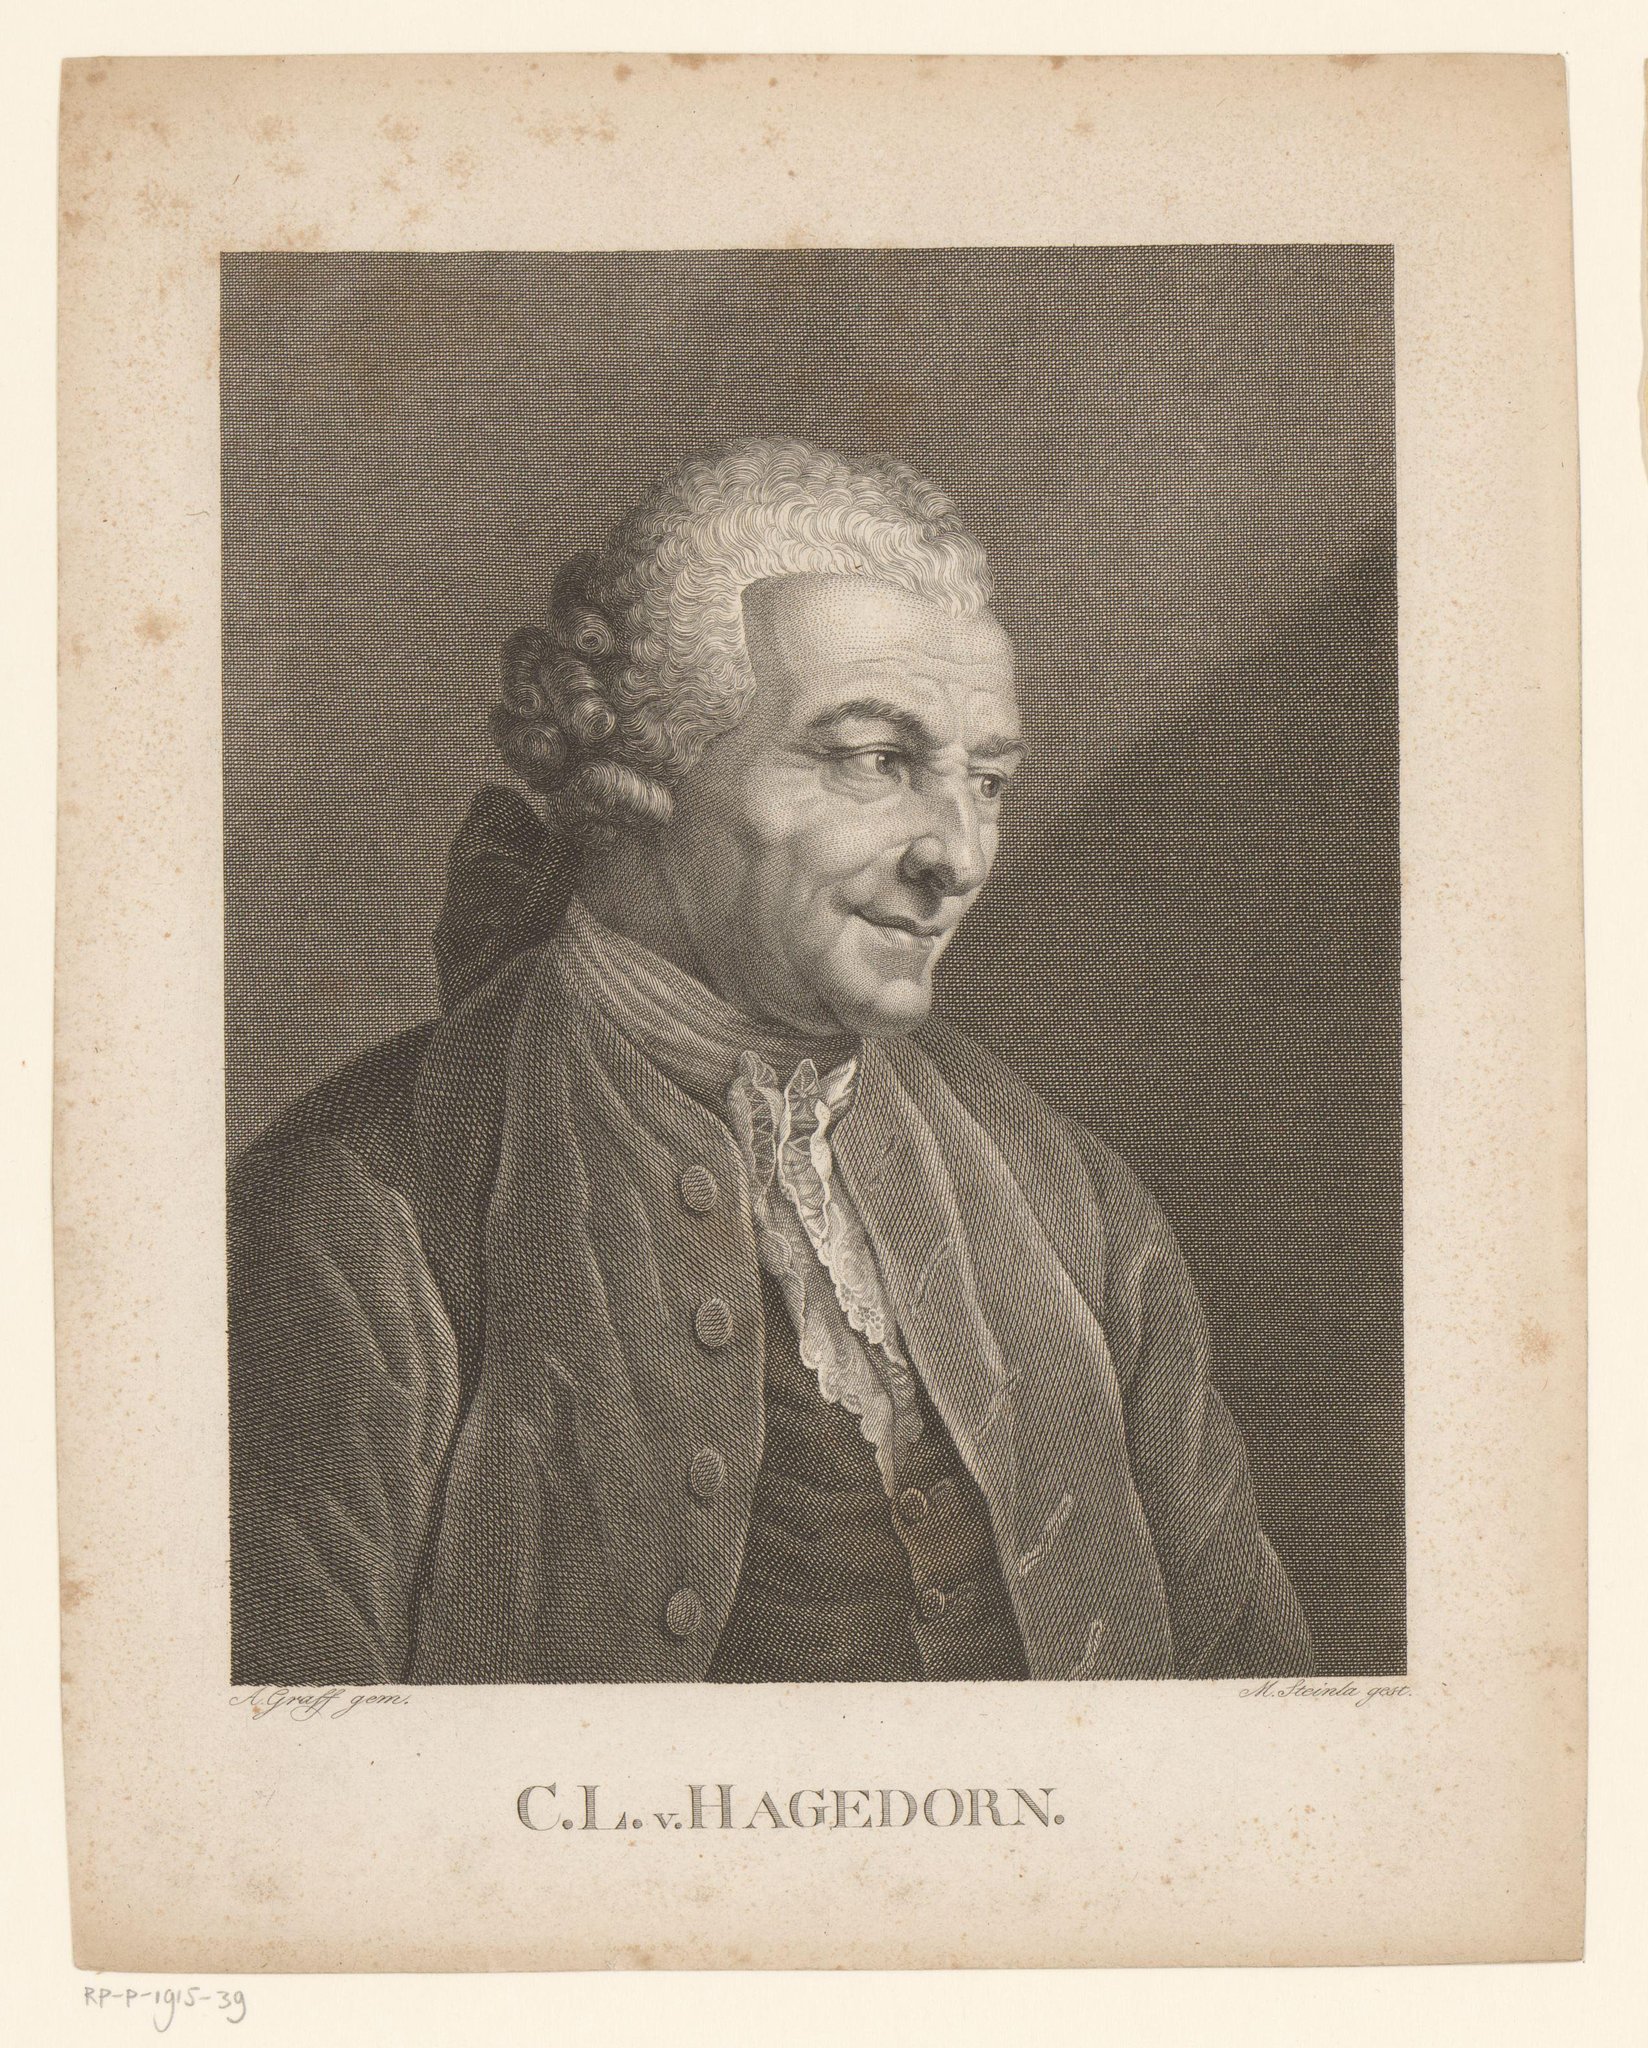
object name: print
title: Portret van Christian Ludwig von Hagedorn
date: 1801-1858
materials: paper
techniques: engraving, etching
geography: germany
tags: painter, christian ludwig von hagedorn, historical persons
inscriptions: collector's mark: Lugt 2228